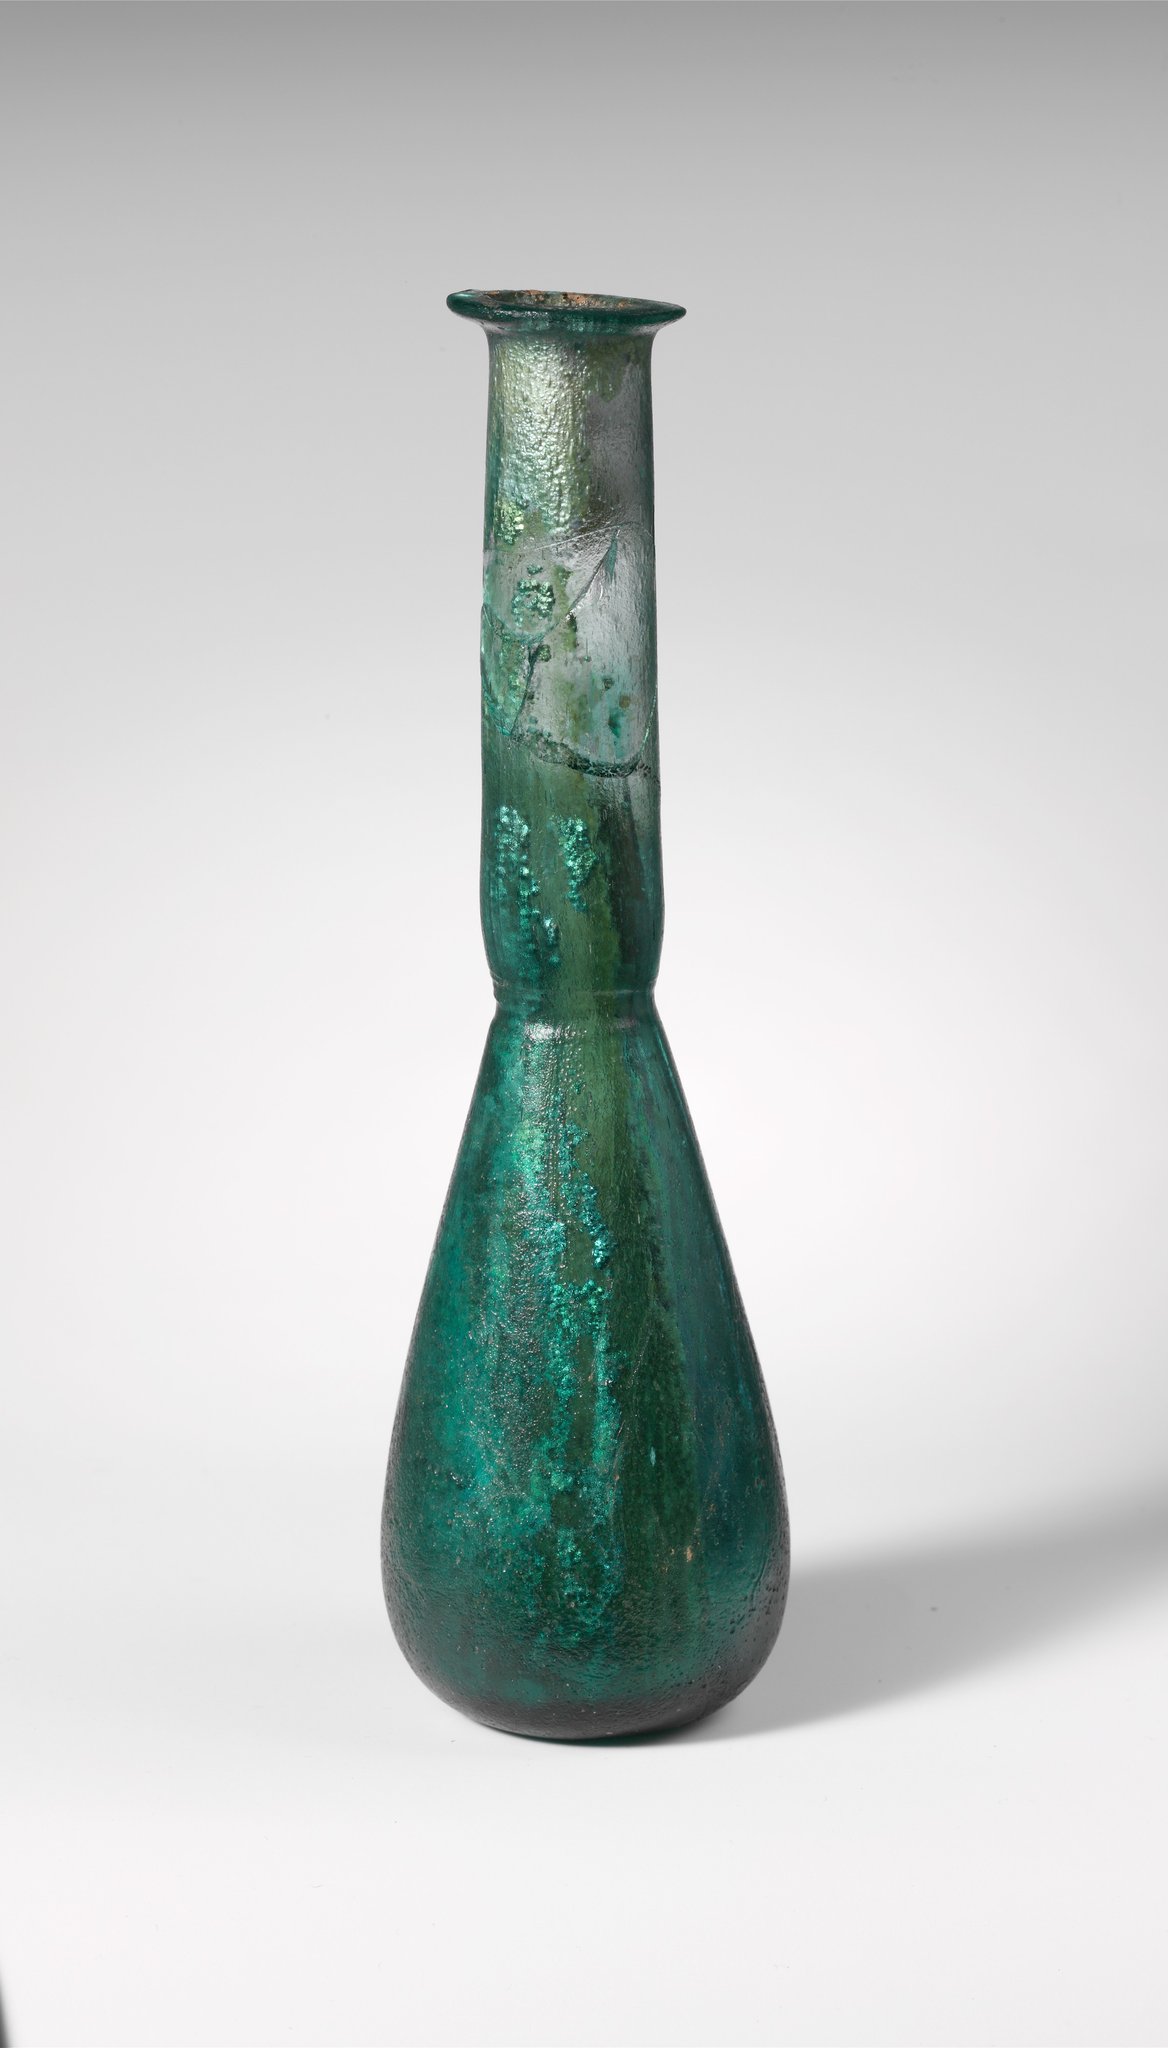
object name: perfume bottle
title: Glass perfume bottle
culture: roman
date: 101-300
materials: glass